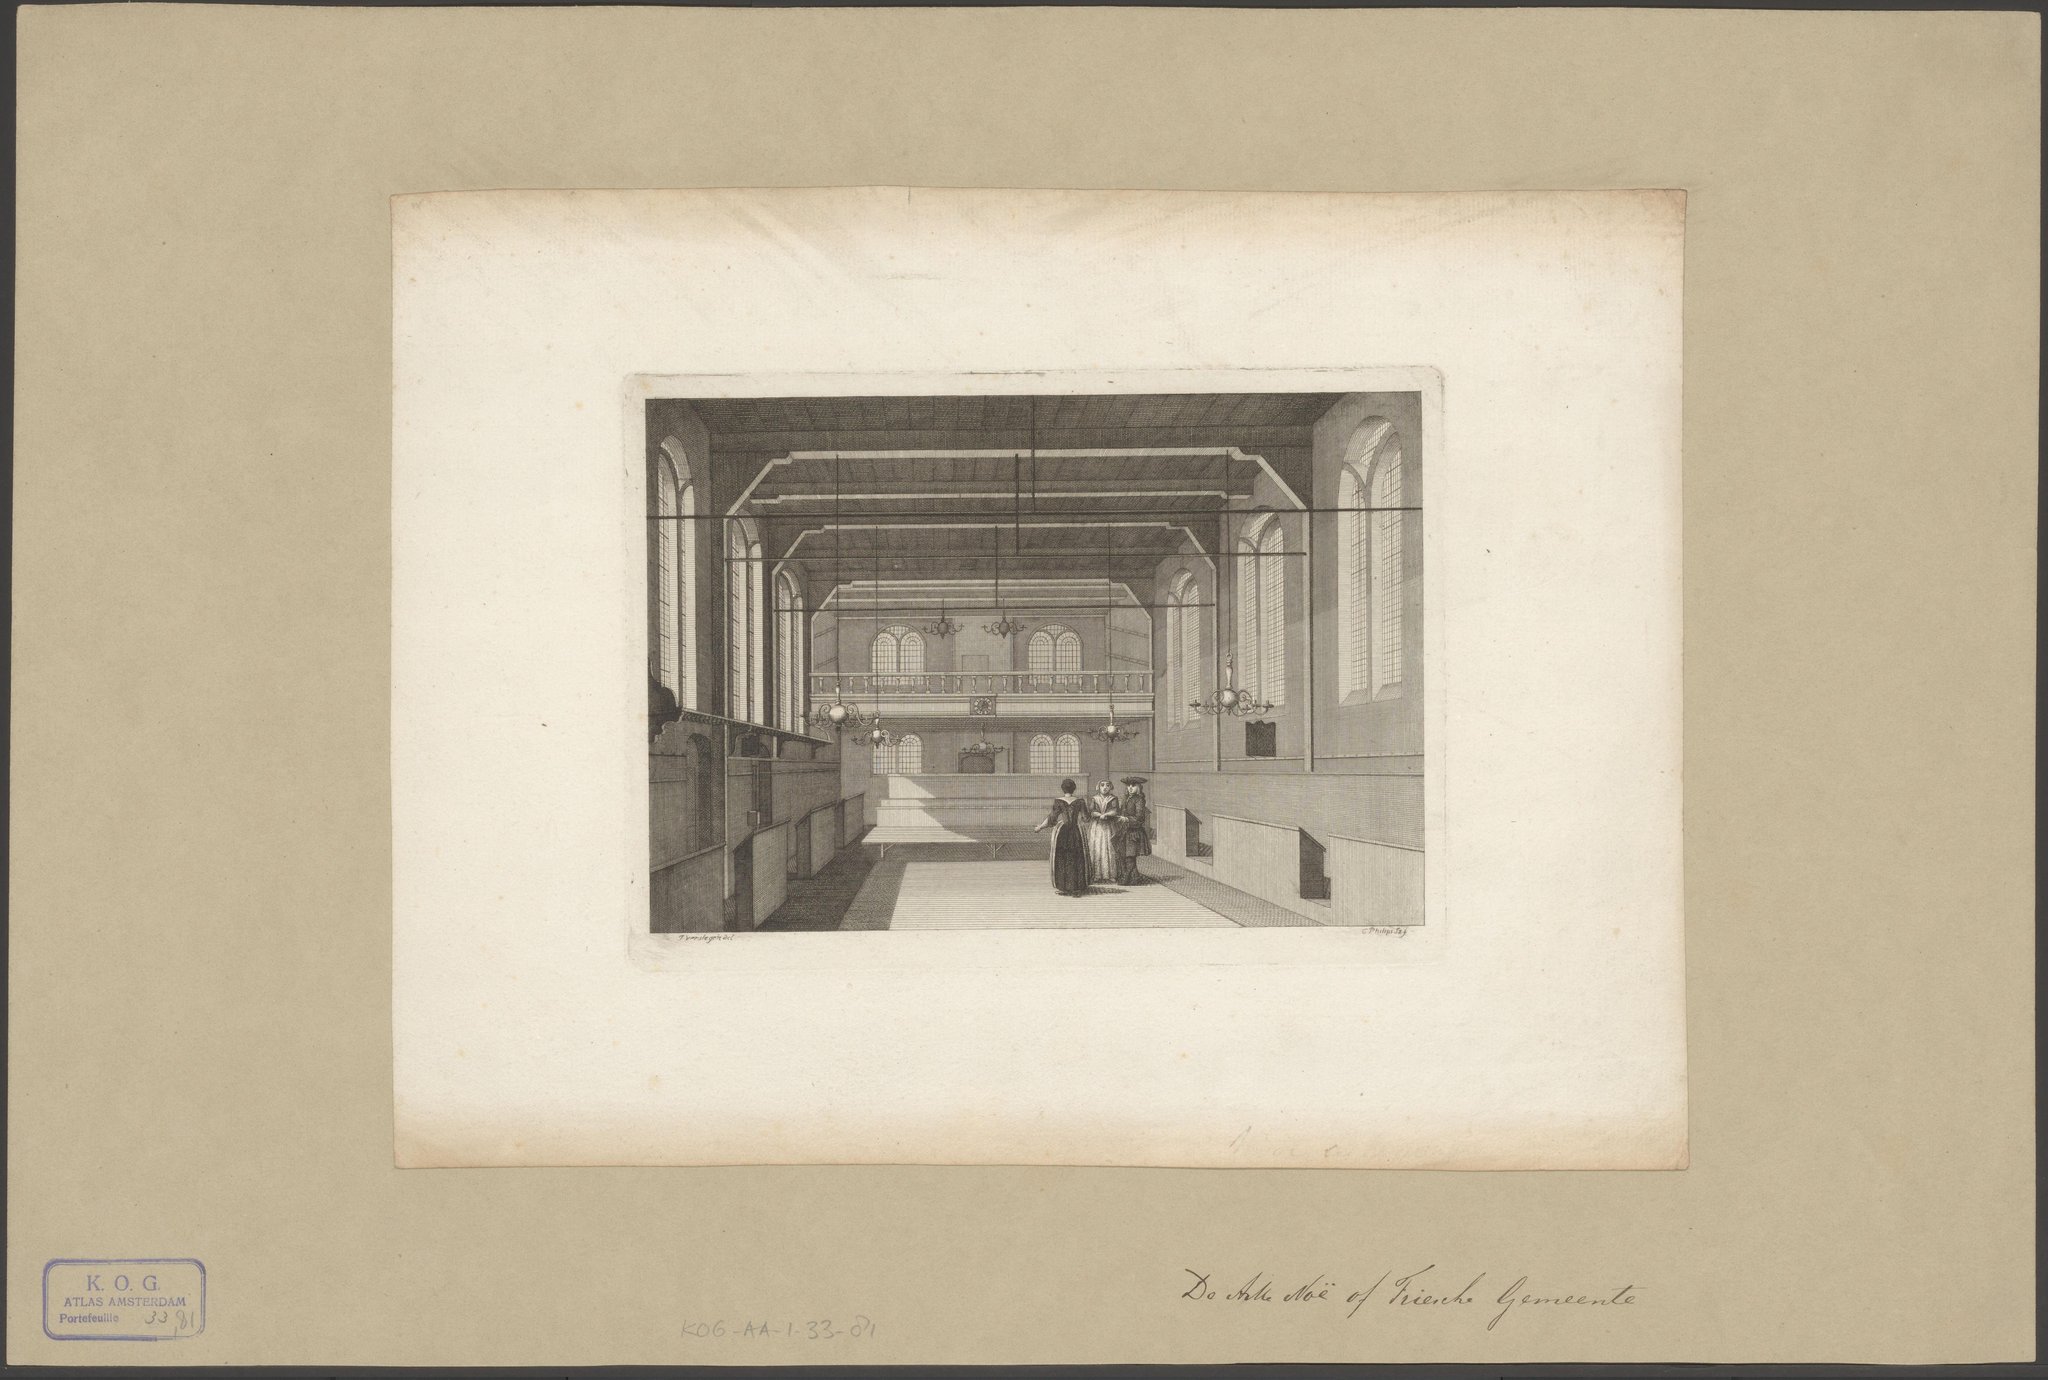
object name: print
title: Interieur van de Doopsgezinde Kerk De Arke Noach te Amsterdam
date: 1752-1789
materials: paper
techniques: etching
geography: amsterdam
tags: protestant churches and denominations (mennonites), interior of church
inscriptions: collector's mark: Lugt 1641b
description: Onderwerpsrubriek binnen de Atlas Amsterdam: Kerkwezen: Gebouwen diverse gemeenten: Doopsgezinde Gemeente / Gebouwen, vroegere kerken (Arke Noachs / Jan Jacobsgezinden / De Toren / De Zon).